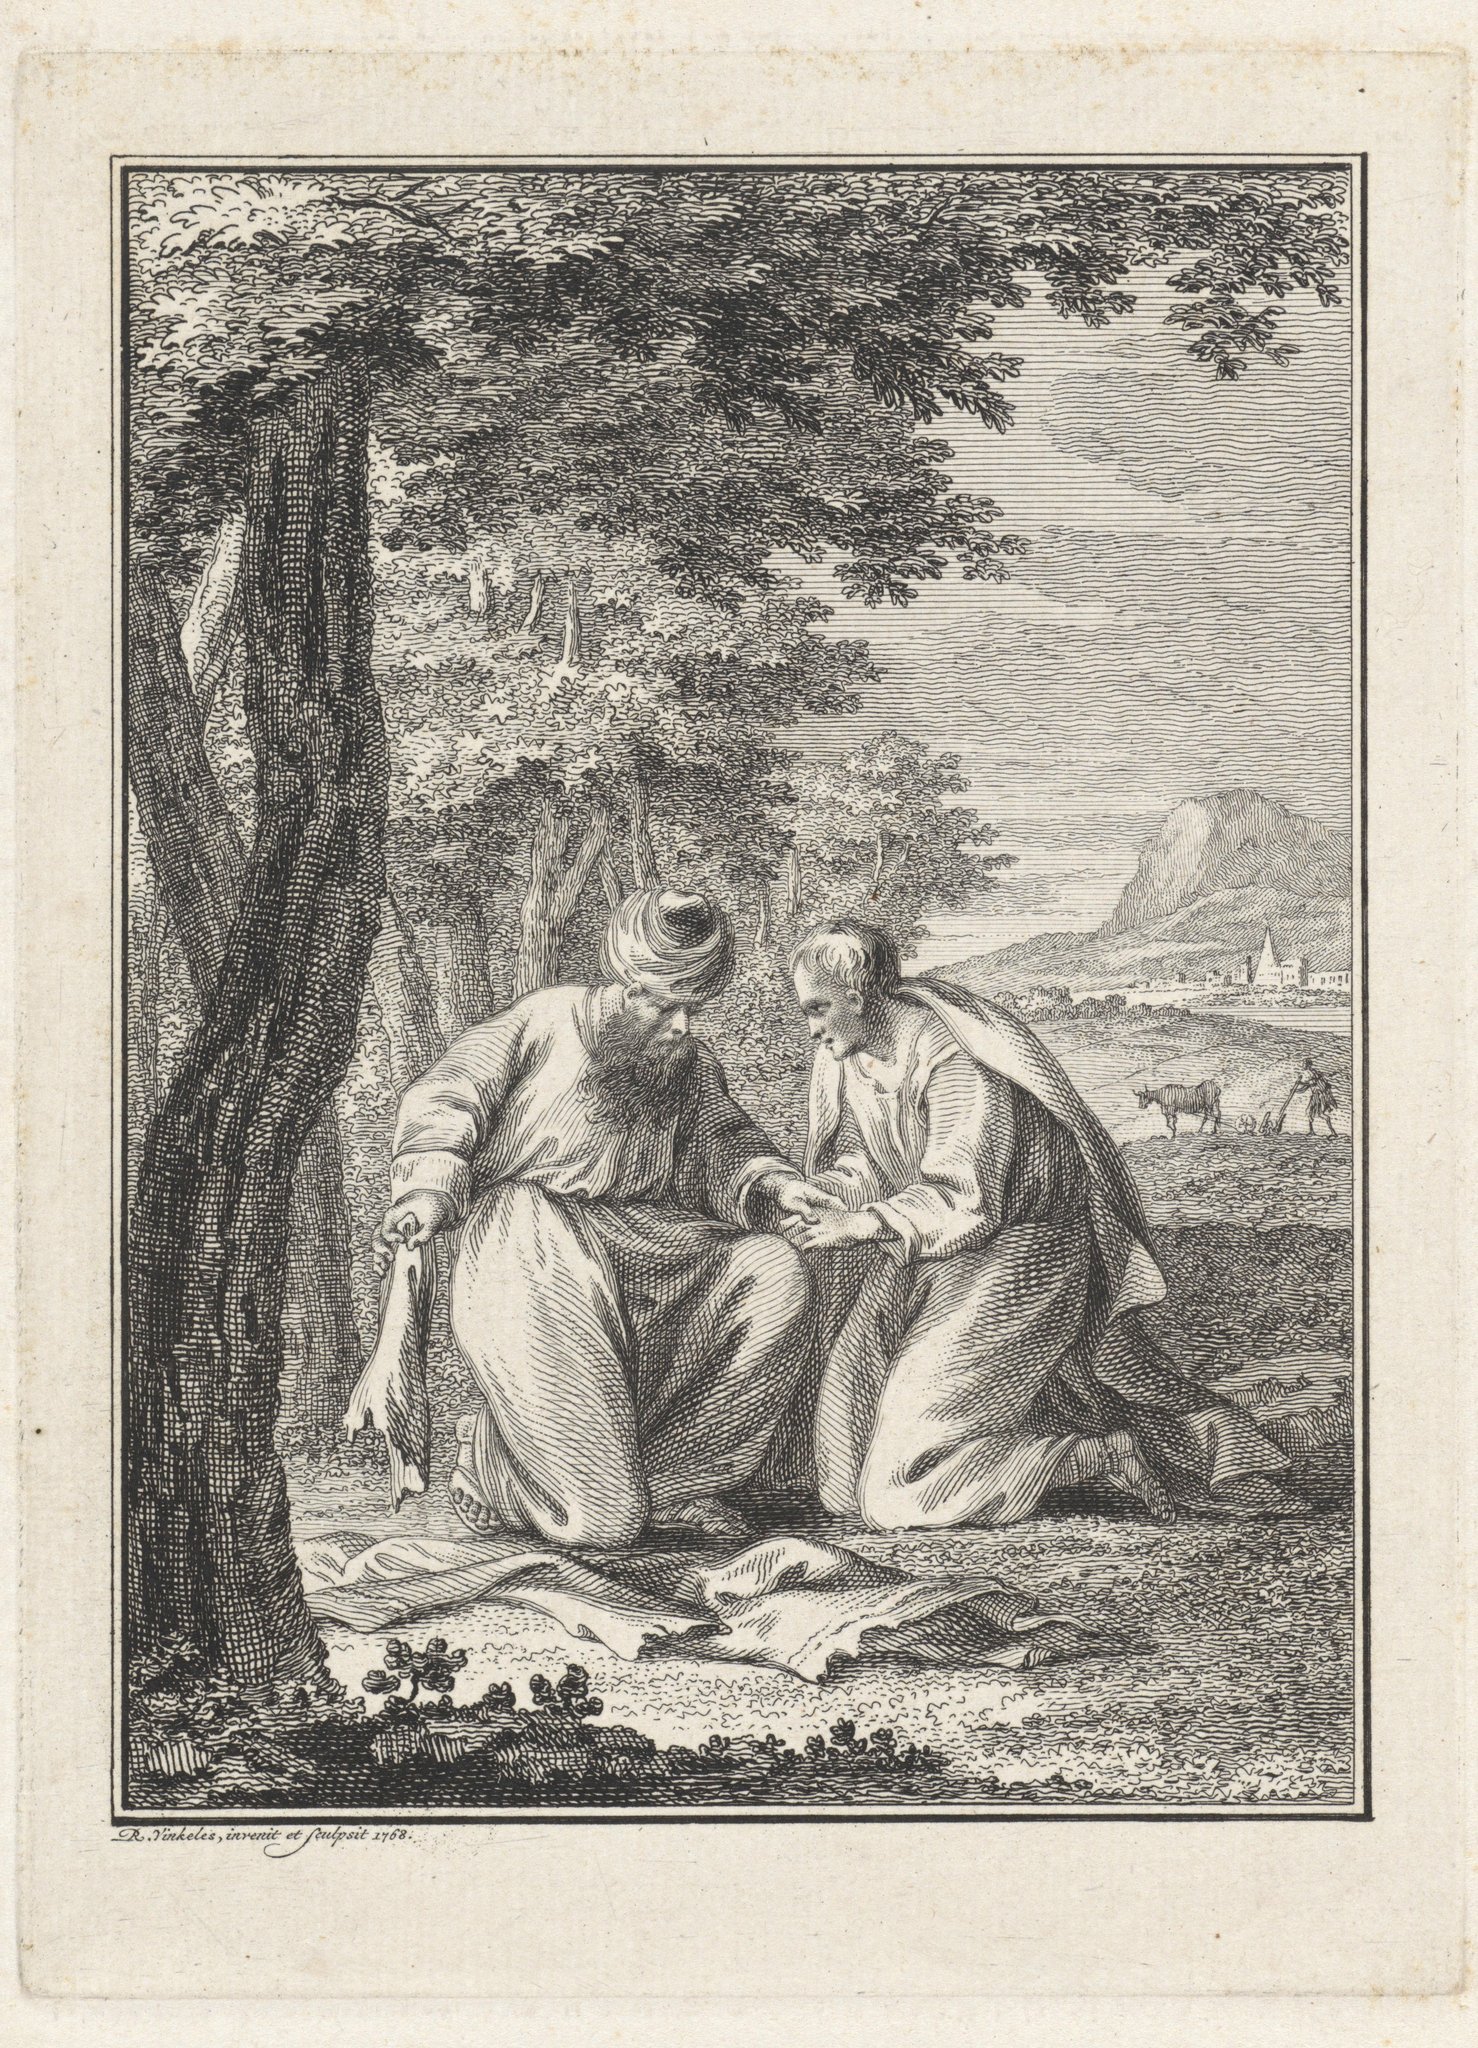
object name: print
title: Jerobeam en de profeet Achia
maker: reinier vinkeles (i)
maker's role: draughtsman, print maker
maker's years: 1741-1816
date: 1768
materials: paper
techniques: engraving, etching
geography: amsterdam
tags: meeting of jeroboam and the prophet ahijah; ahijah rends his garment in twelve pieces, ten of which he gives to jeroboam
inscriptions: collector's mark: Lugt 240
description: De profeet Achia heeft zijn mantel in twaalf stukken gescheurd en overhandigt tien stukken aan Jerobeam. De gescheurde mantel staat symbool voor de splitsing van het Joodse volk. Jerobeam werd koning van tien van de twaalf stammen.